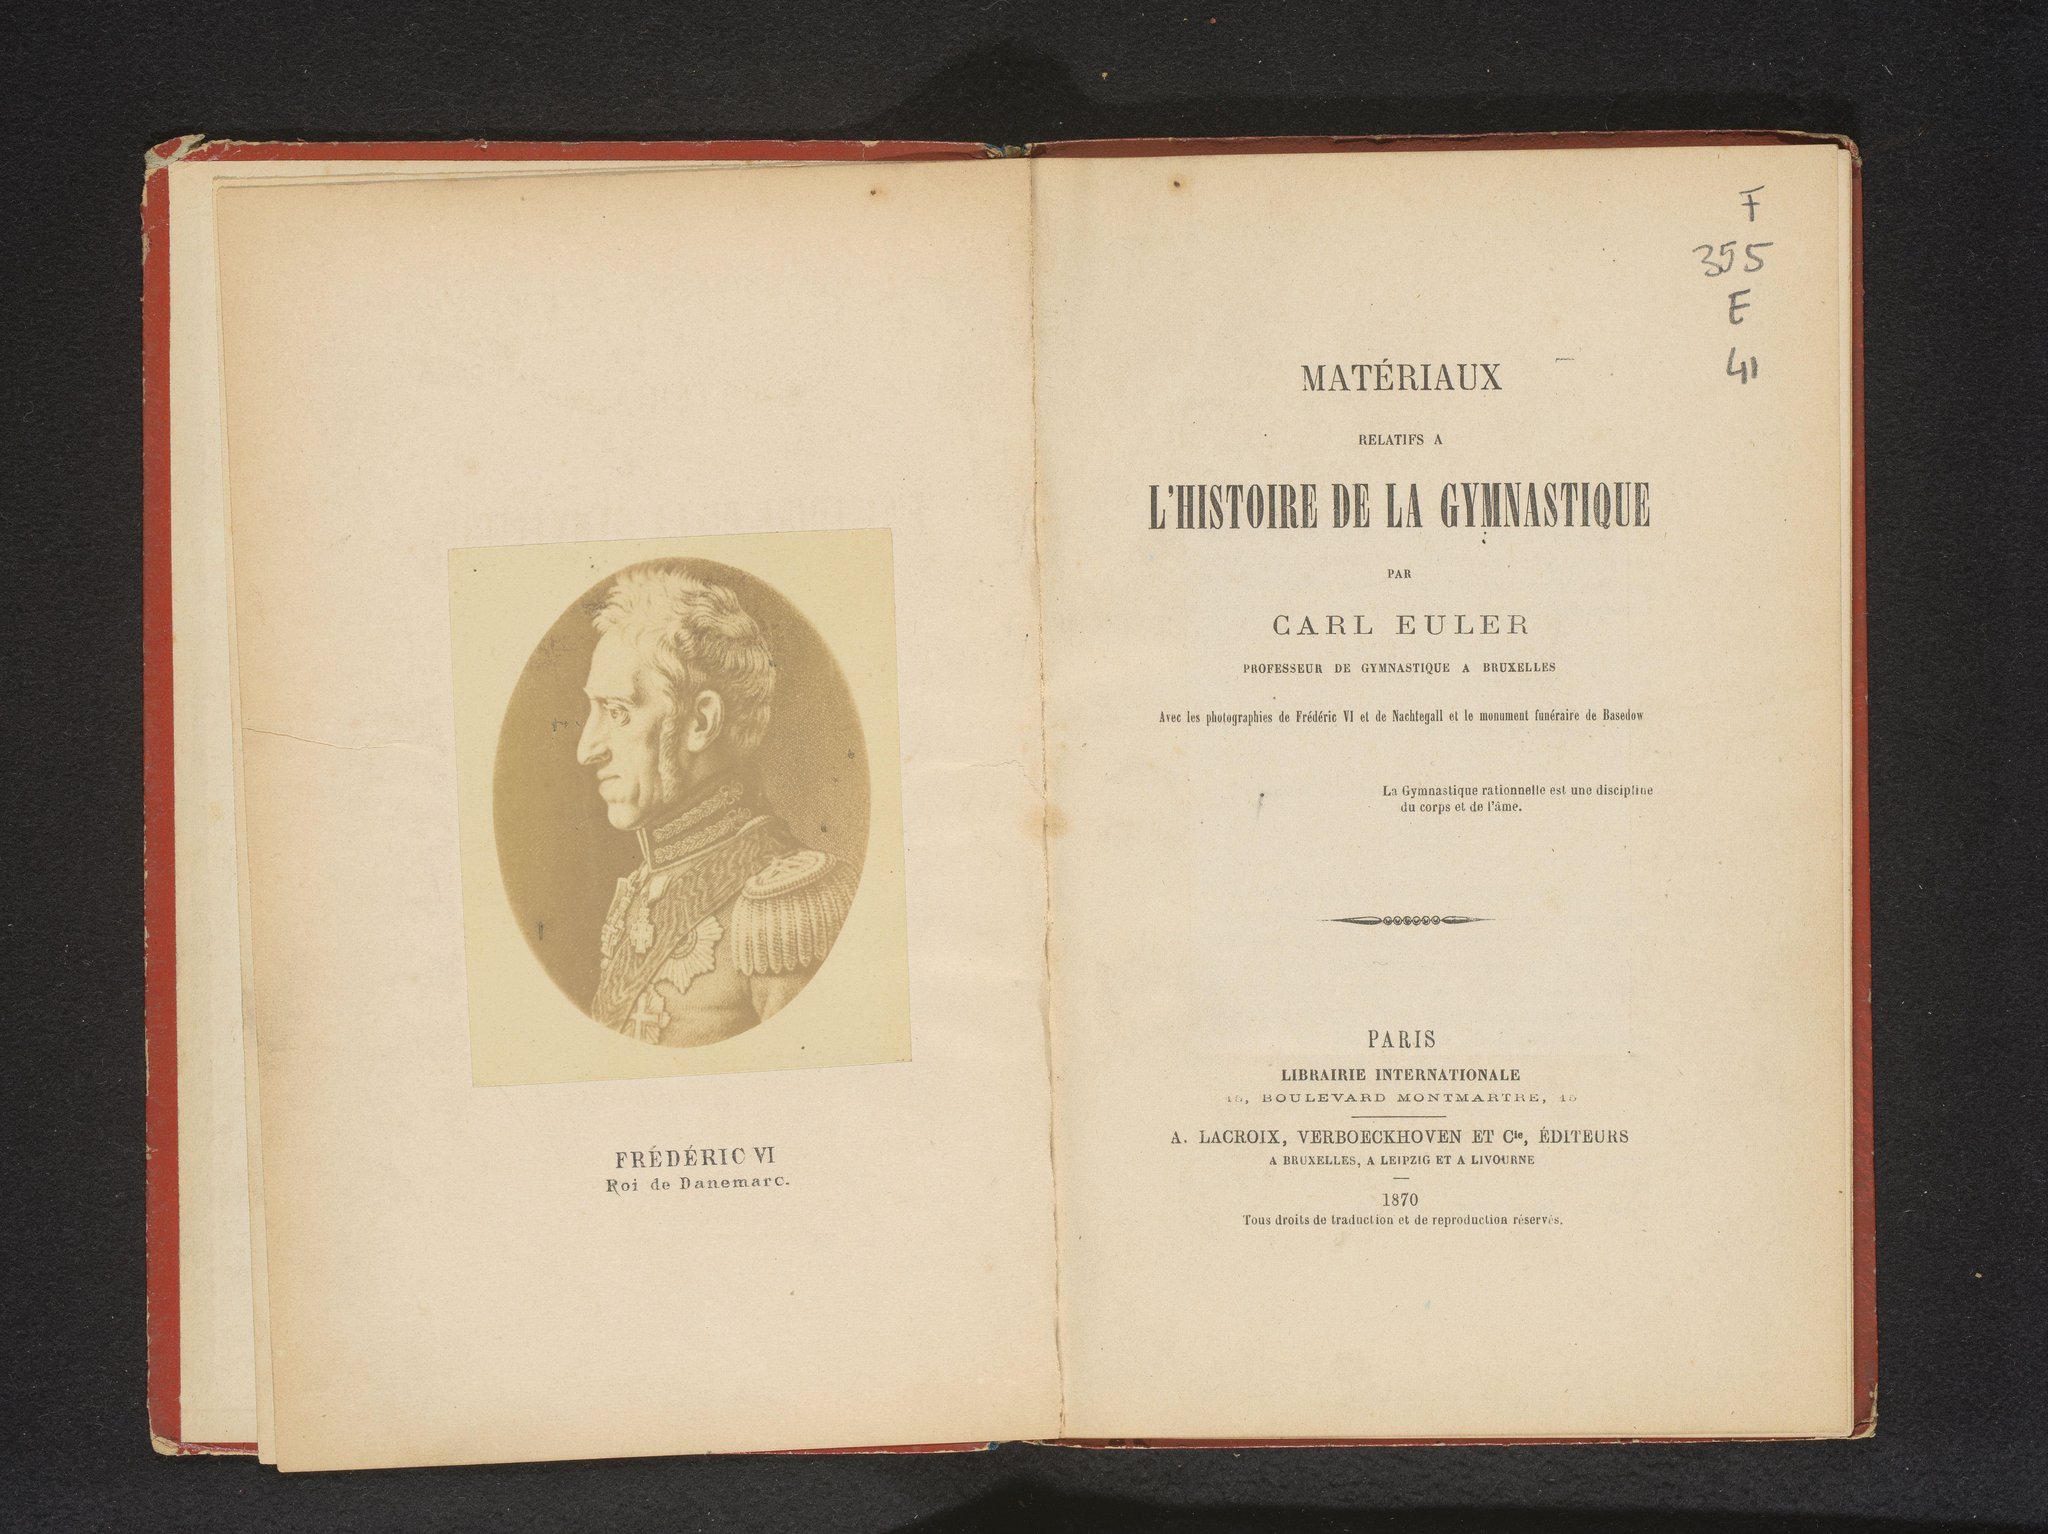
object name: page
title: Fotoreproductie van een portret van Frederik VI van Denemarken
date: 1867-1877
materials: photographic support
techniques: albumen print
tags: ruler, sovereign